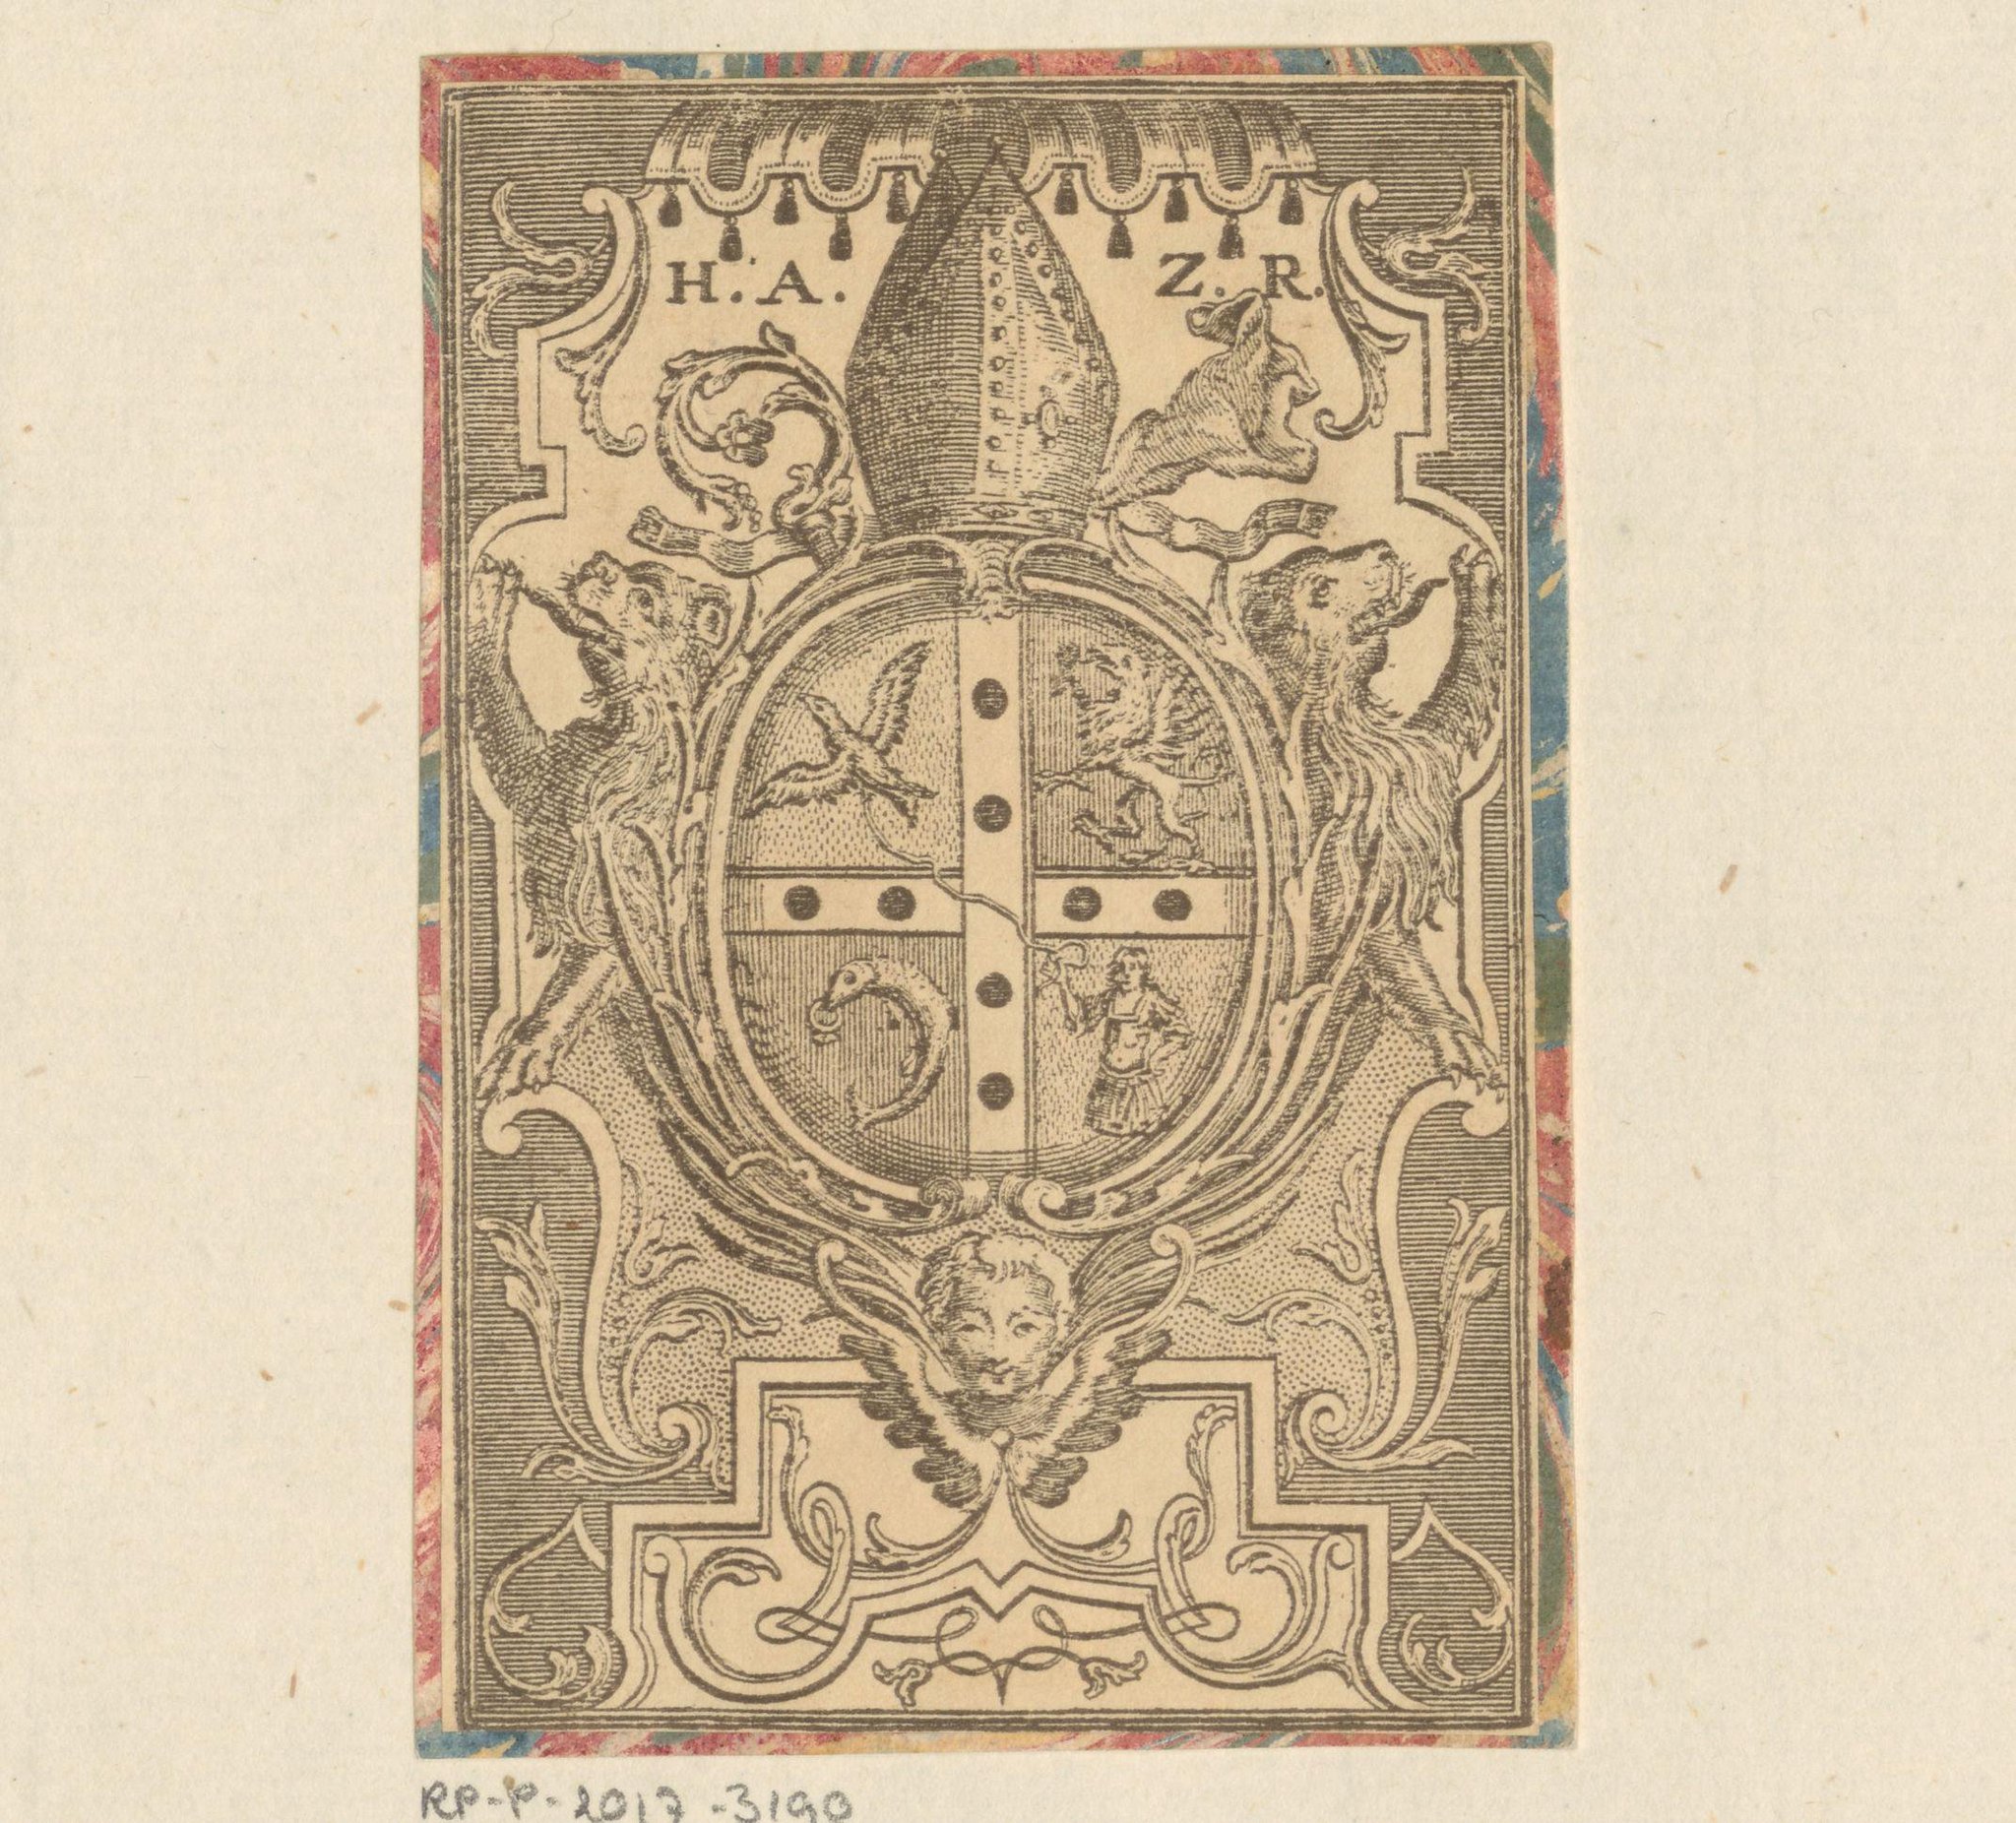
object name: bookplate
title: Ex libris van H.A.Z.R.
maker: Anonymous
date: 1650-1750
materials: paper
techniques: etching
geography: germany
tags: cherubs, i.e. children's heads with wings, insignia of bishop, e.g. mitre, crozier, beasts of prey, predatory animals: lion, armorial bearing, heraldry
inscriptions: inscription: ‘Roth / Monta[...] / Prämonstrantenser / Abtei in Schwaben / Abtei Roth [...] / W. 1795 / 1.80’